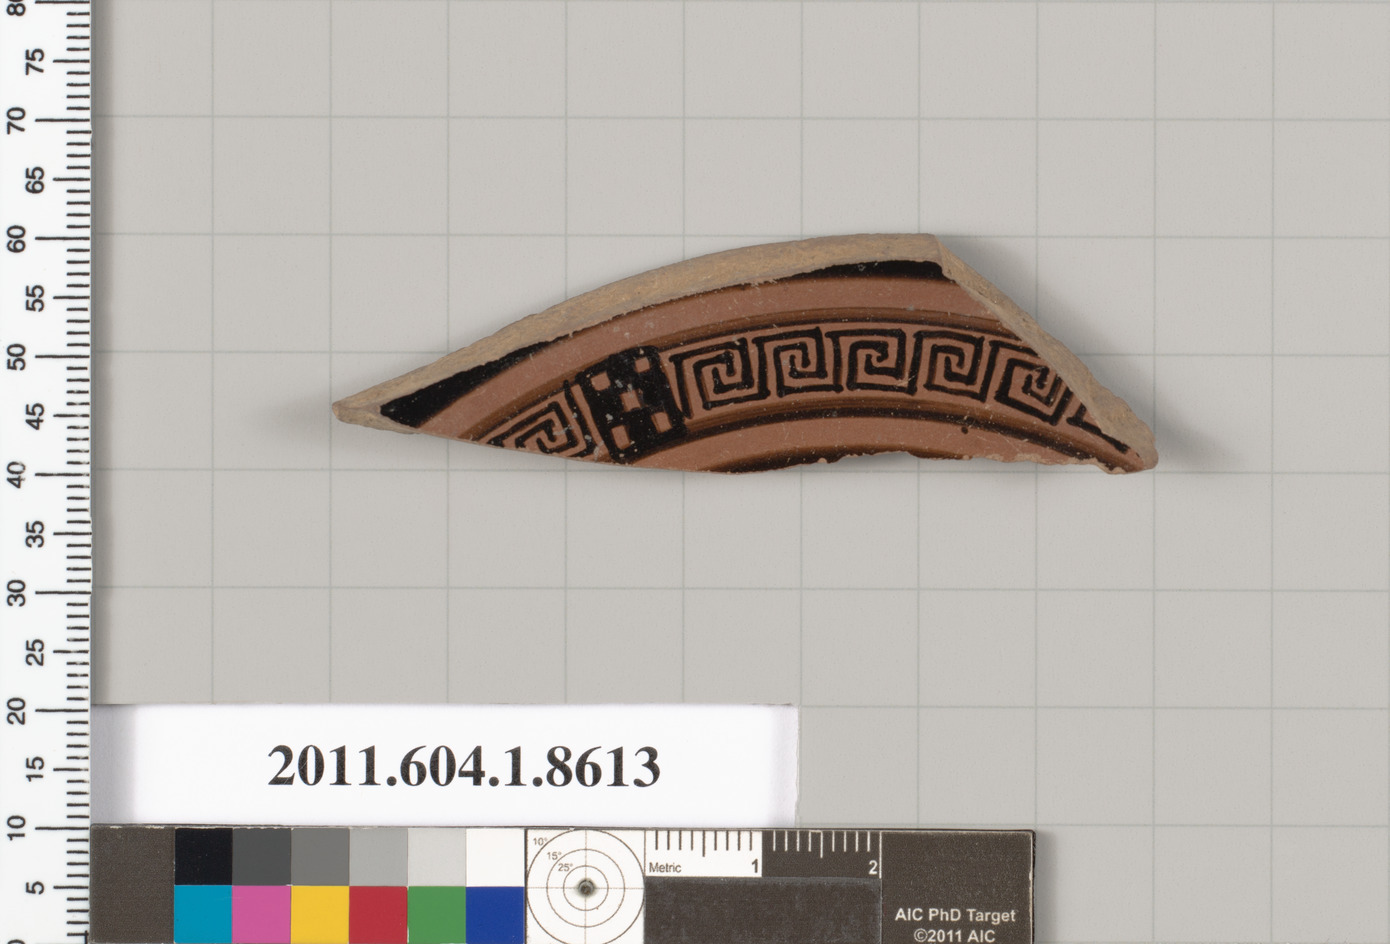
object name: kylix fragment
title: Terracotta fragment of a stemless kylix (drinking cup)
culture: greek, attic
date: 470-450 BCE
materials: terracotta